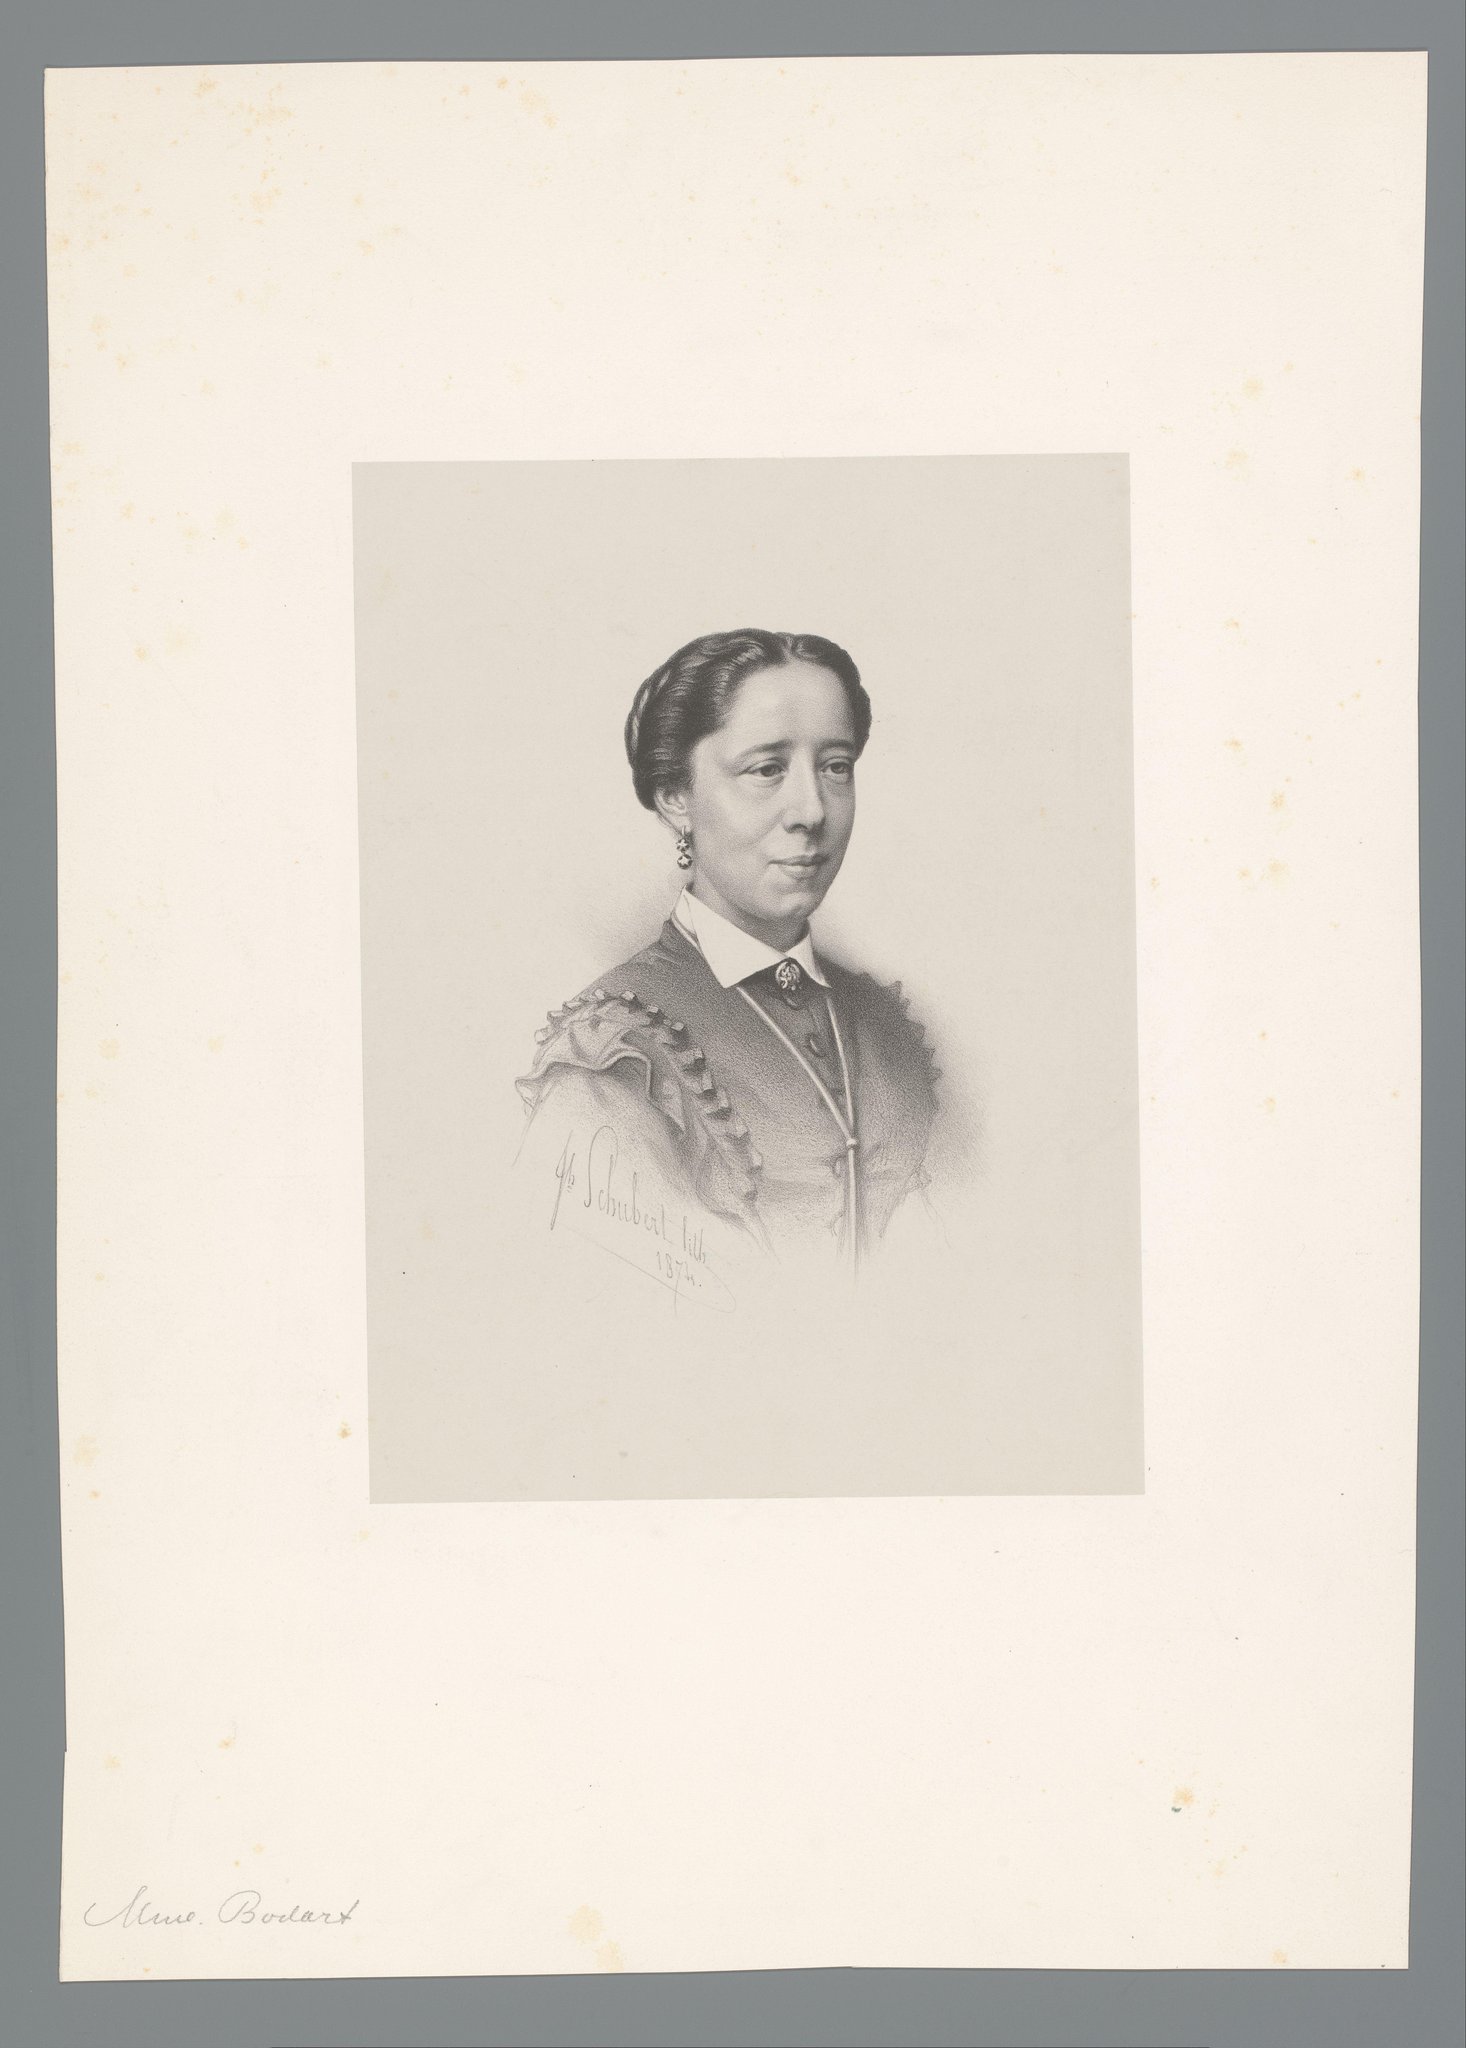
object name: print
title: Portret van mevrouw Bodart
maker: joseph schubert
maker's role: print maker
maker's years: 1816-1885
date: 1874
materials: paper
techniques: lithograph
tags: historical persons - bb - woman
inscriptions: collector's mark: Lugt 2228, annotation: ‘Mme. Bodart’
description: Portret van een vrouw met de achternaam Bodart.